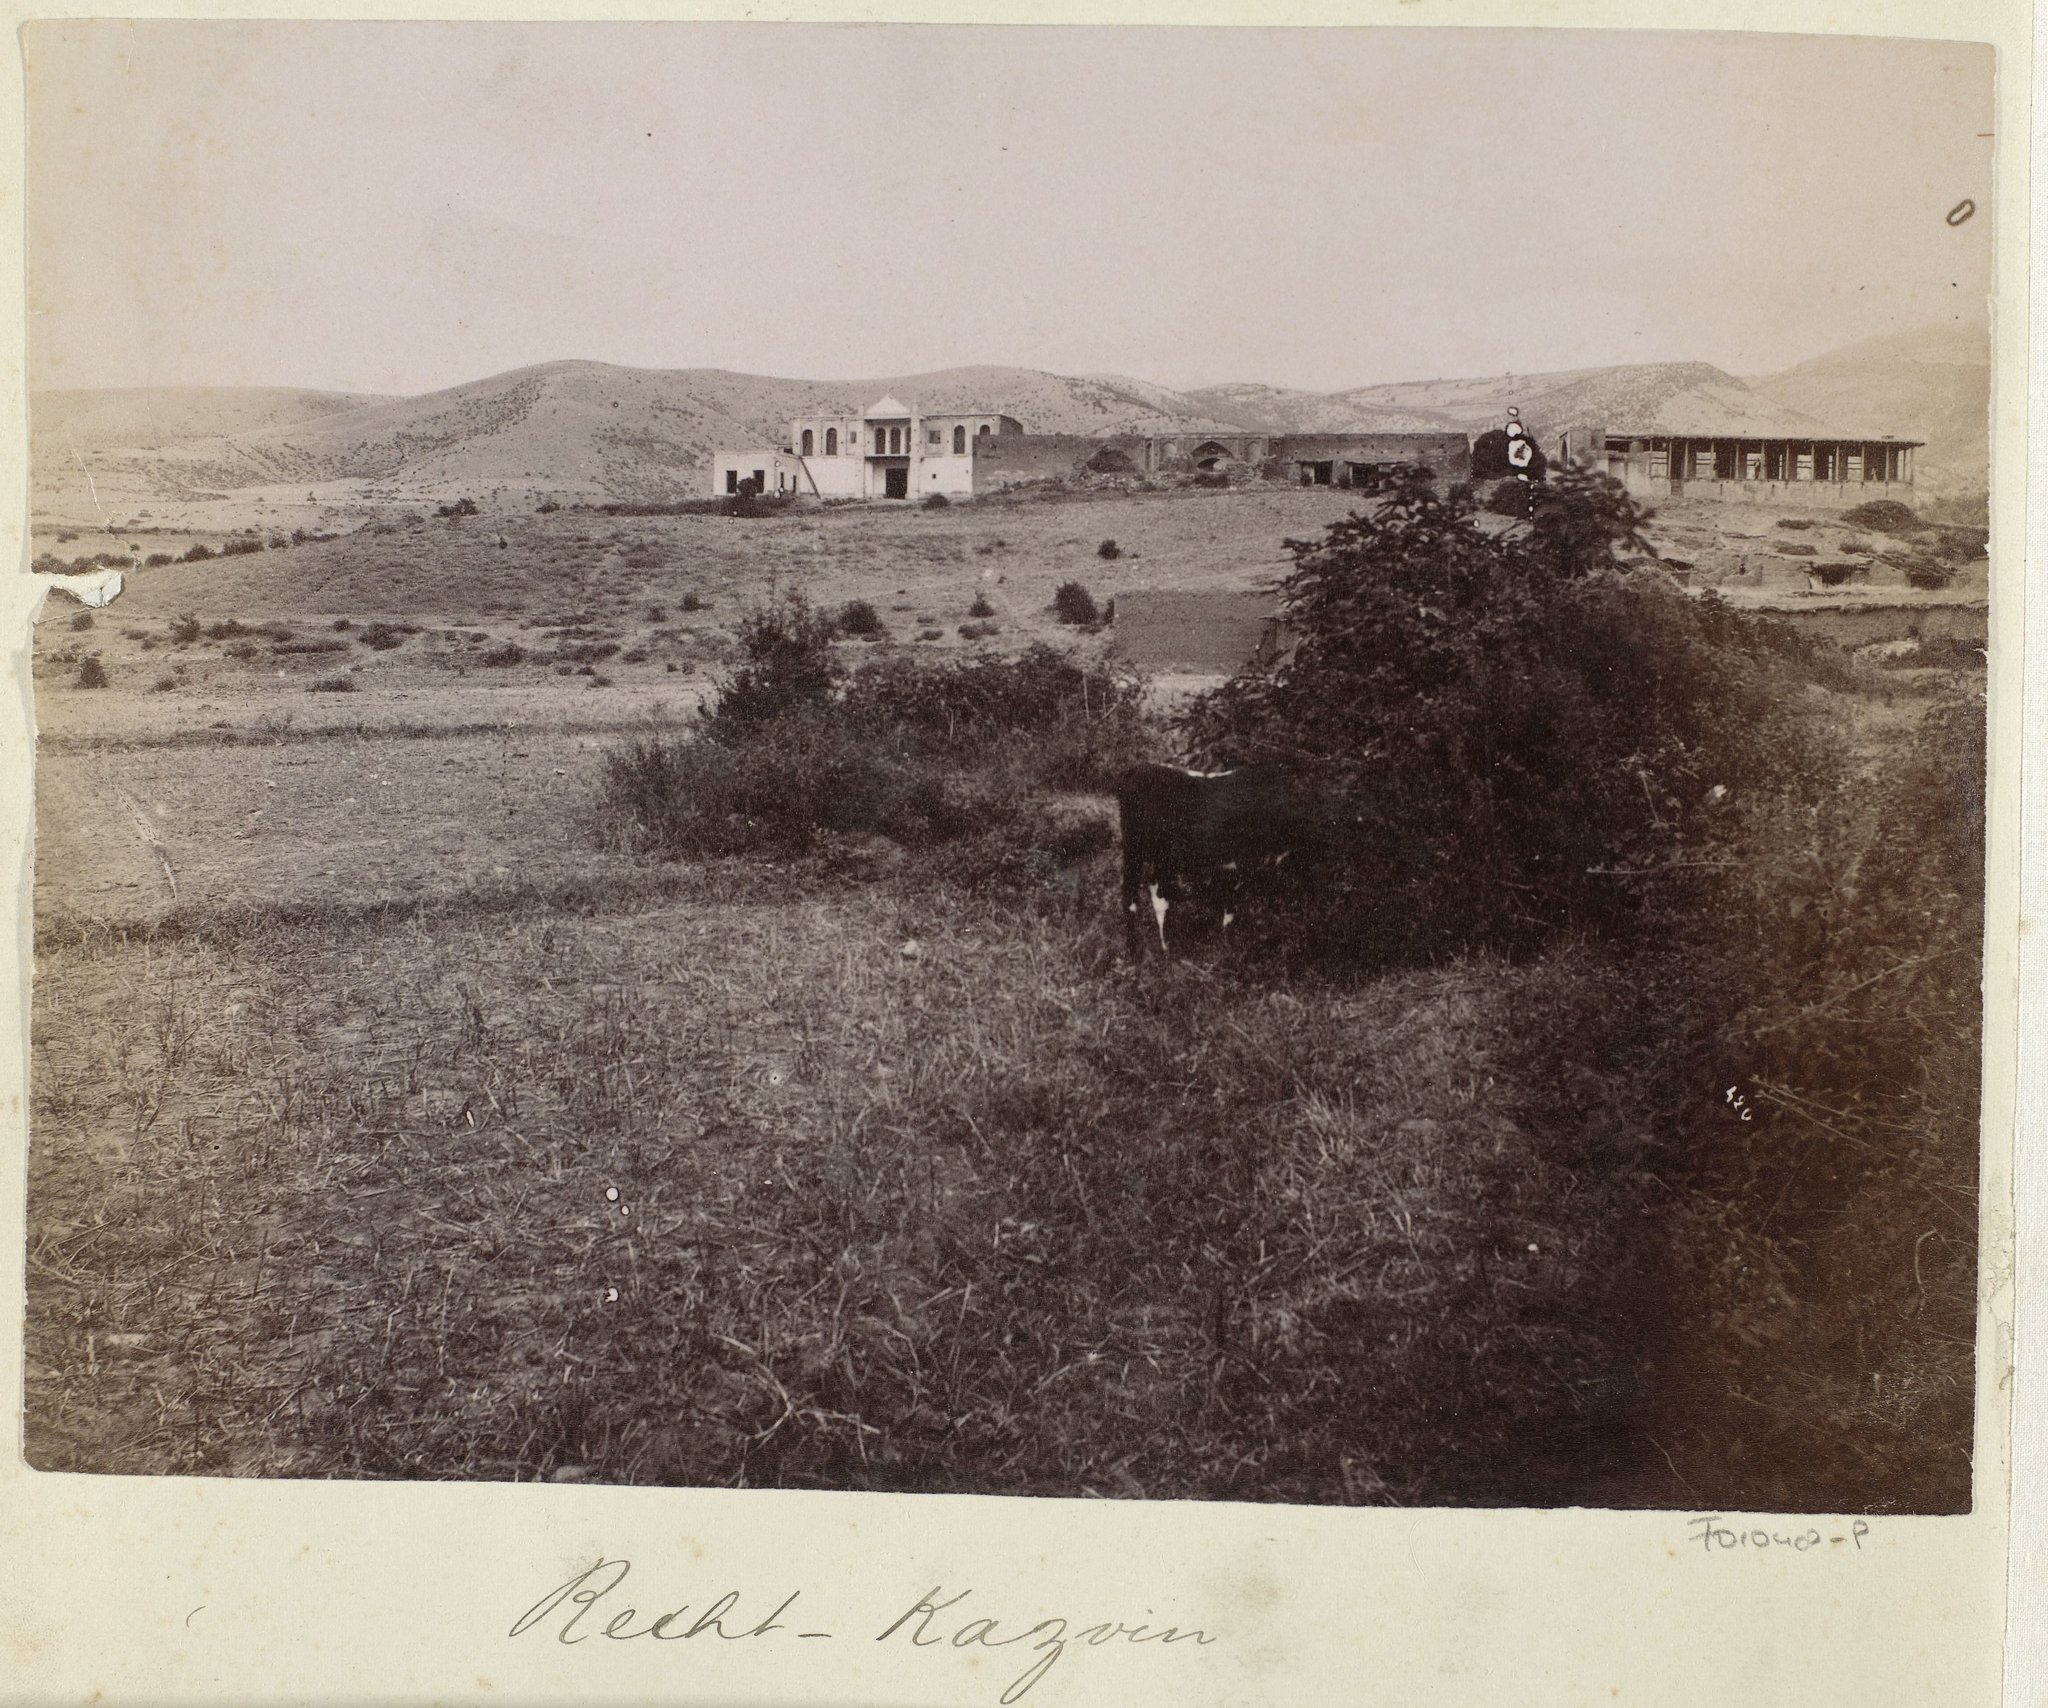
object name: photograph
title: Landschap met huizen in Qazvin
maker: antoine sevruguin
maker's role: fotograaf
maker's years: 1840-1933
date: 1880-1895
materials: paper, photographic support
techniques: albumen print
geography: qazvin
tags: qazvin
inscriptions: negative number: ‘420’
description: Onderdeel van Reisalbum van H. Dunlop met foto's van bezienswaardigheden in Perzië, Schotland, Duitsland, Rusland, China en Canada.